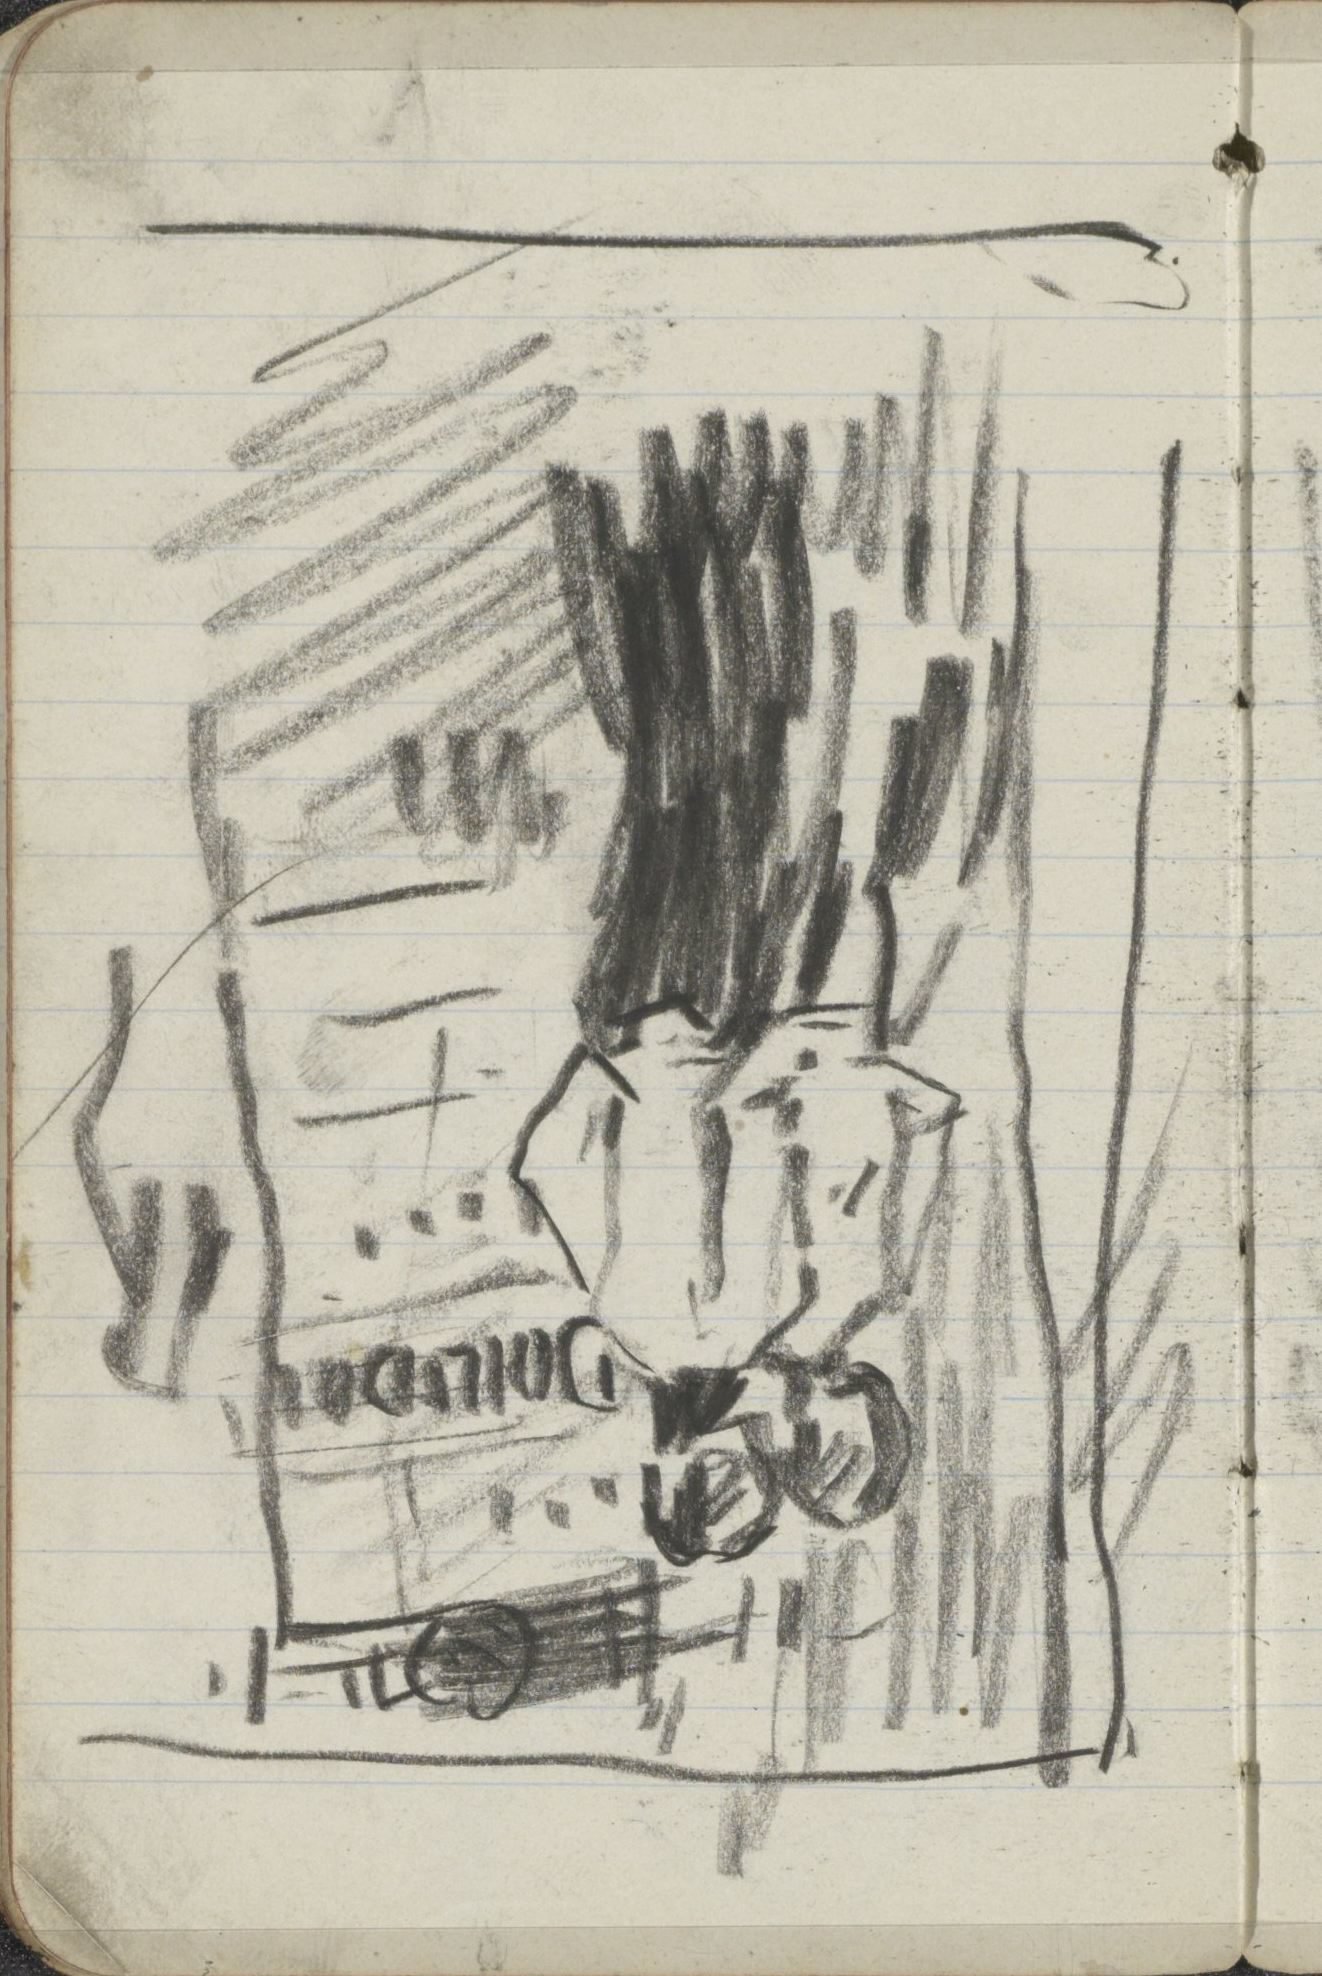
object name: sketchbook leaf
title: Twee figuren voor een gebouw of aanplakbiljet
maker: george hendrik breitner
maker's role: draughtsman, painter, print maker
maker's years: 1857-1923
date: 1894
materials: chalk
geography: amsterdam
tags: adult woman, adult man, civic architecture; edifices; dwellings, poster, amsterdam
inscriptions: inscription: ‘Doil[...]’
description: Pagina 41 uit een schetsboek met 31 bladen.